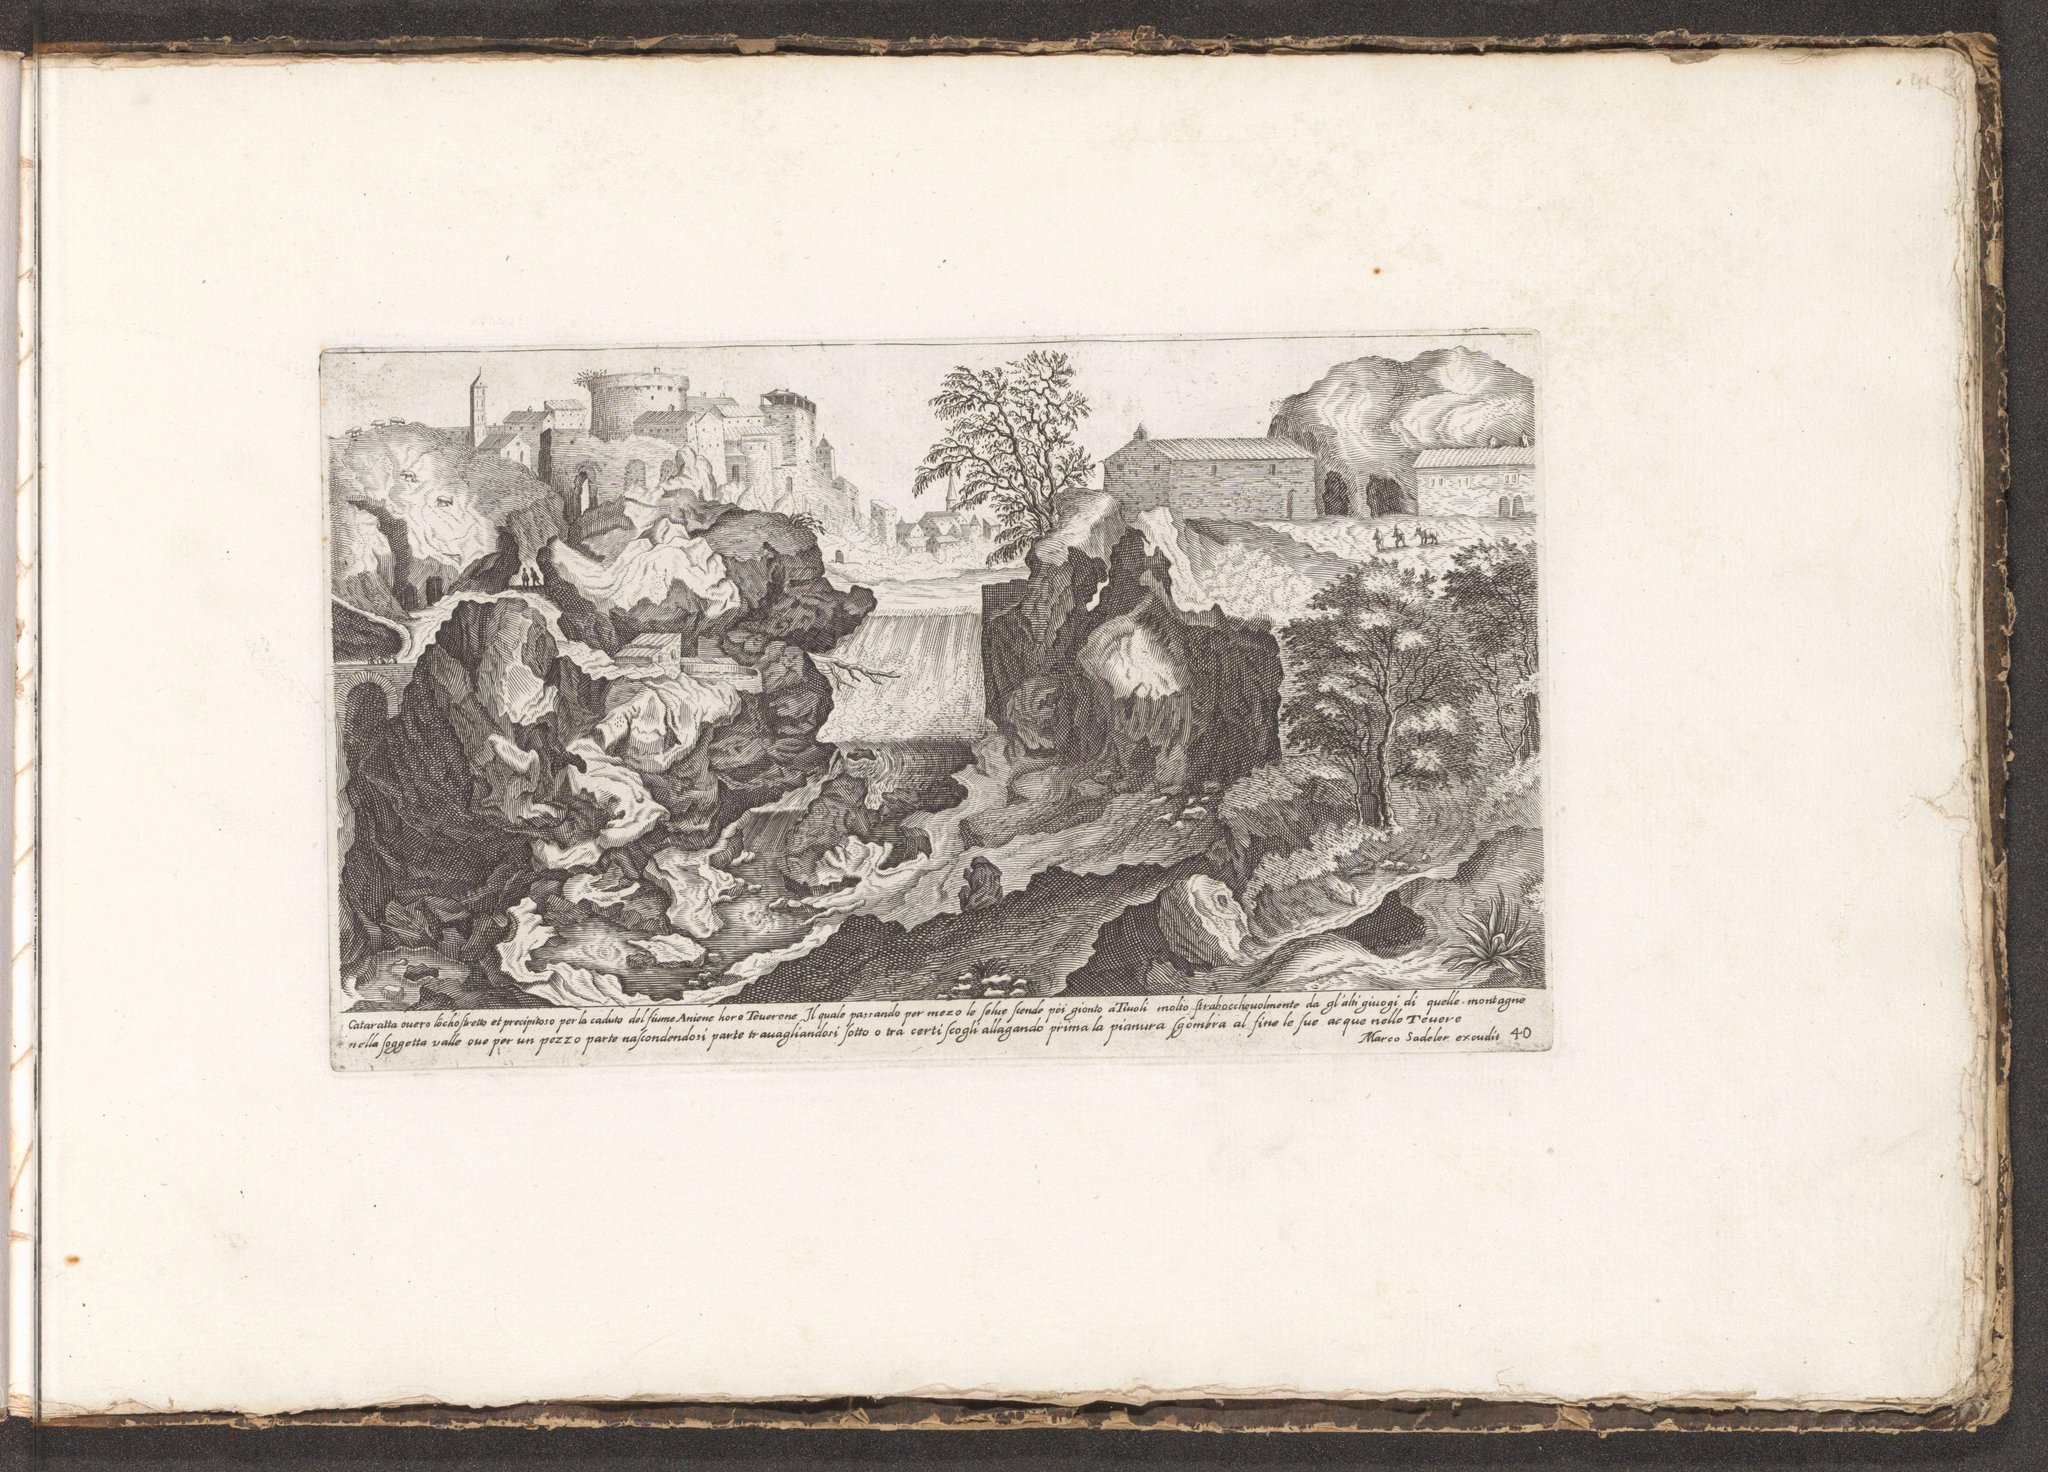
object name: album leaf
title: Gezicht op de Tiber bij Tivoli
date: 1680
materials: paper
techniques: engraving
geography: antwerp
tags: river, landscapes in the temperate zone, rome, tivoli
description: Gezicht op de rivier de Tiber bij Tivoli. In het midden van het landschap een waterval. Links Tivoli. In de ondermarge twee regels tekst in het Italiaans. De prent maakt deel uit van een album.